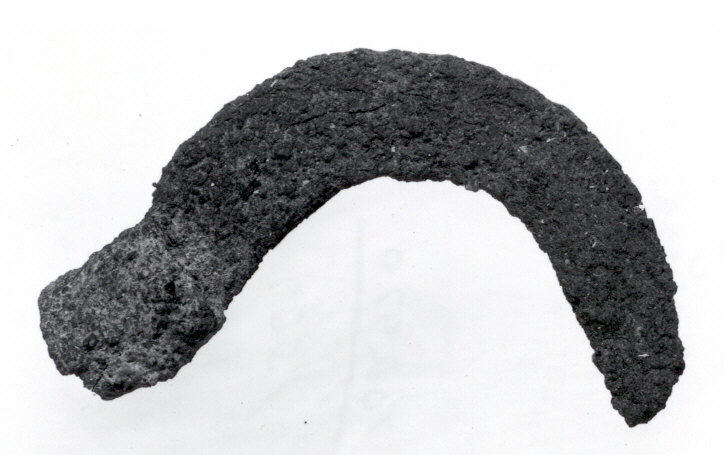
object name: sickle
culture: islamic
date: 801-1000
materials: iron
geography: iran